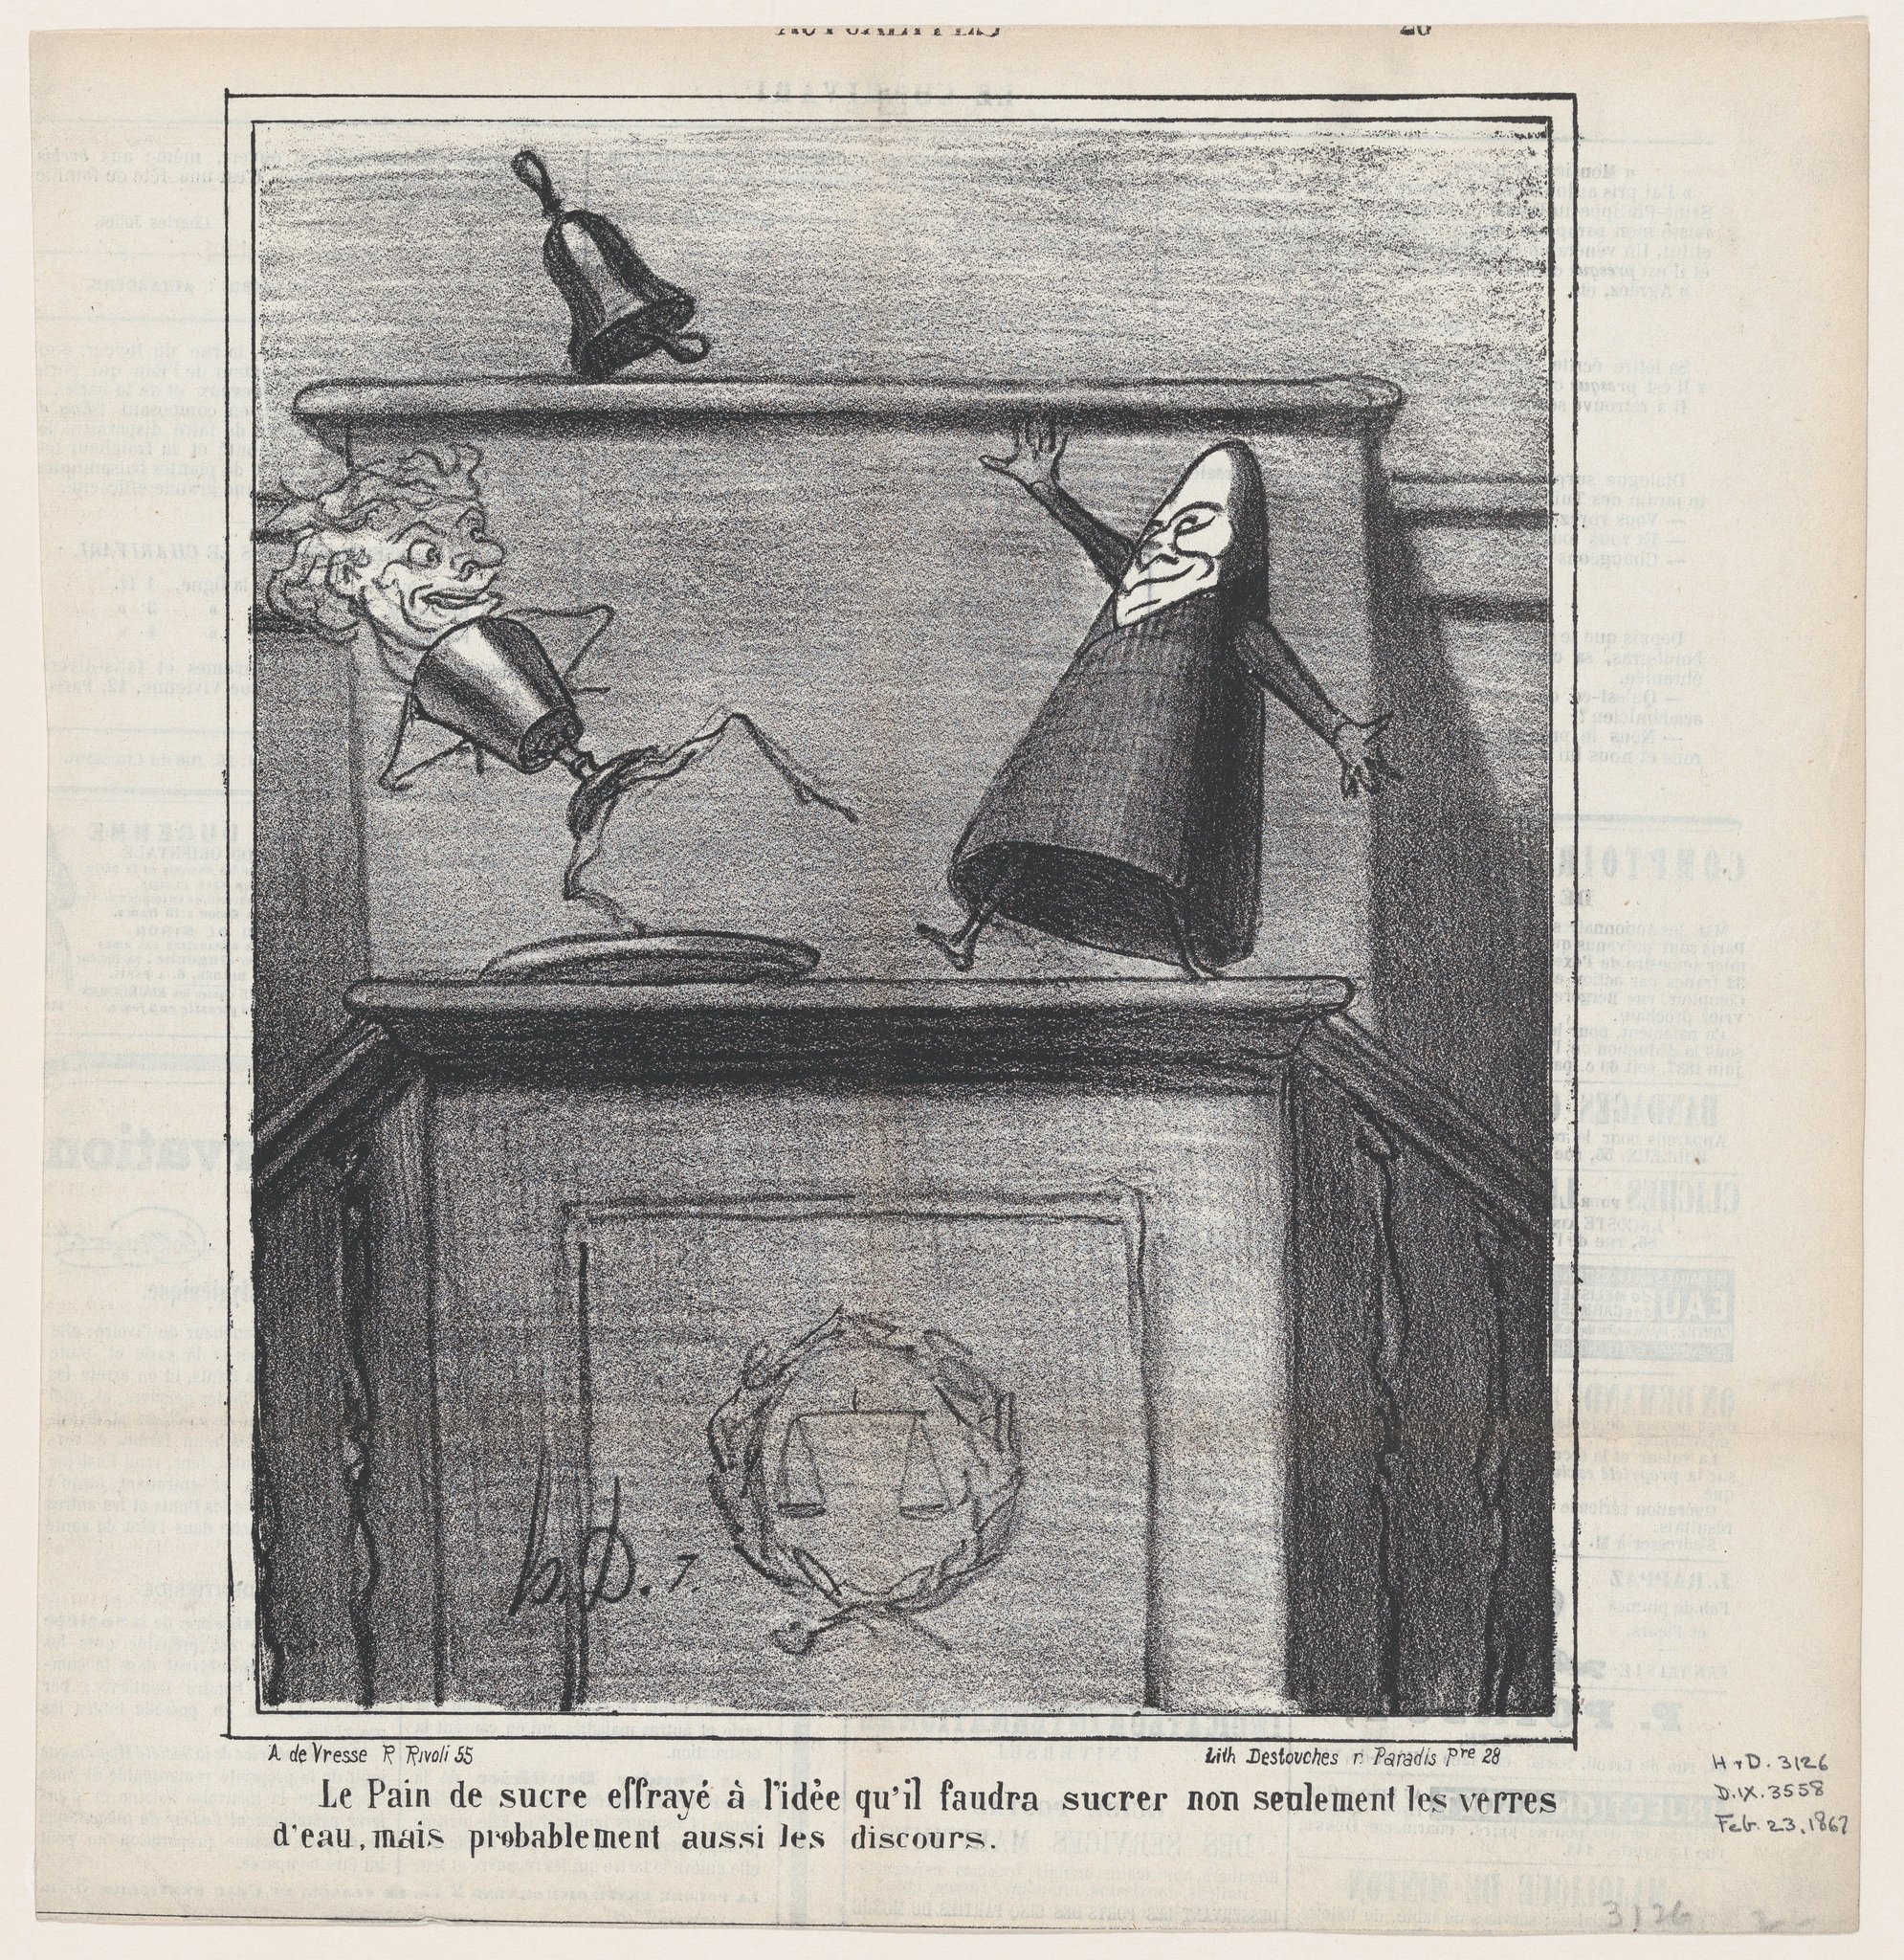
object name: print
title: The loaf of sugar frightened at the idea that it will be necessary not only to sweeten the water of the orators but probably also their speeches, from "News of the Day"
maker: honoré daumier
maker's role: artist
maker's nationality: french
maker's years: 1808-1879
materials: paper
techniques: lithograph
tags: musical instruments,satire